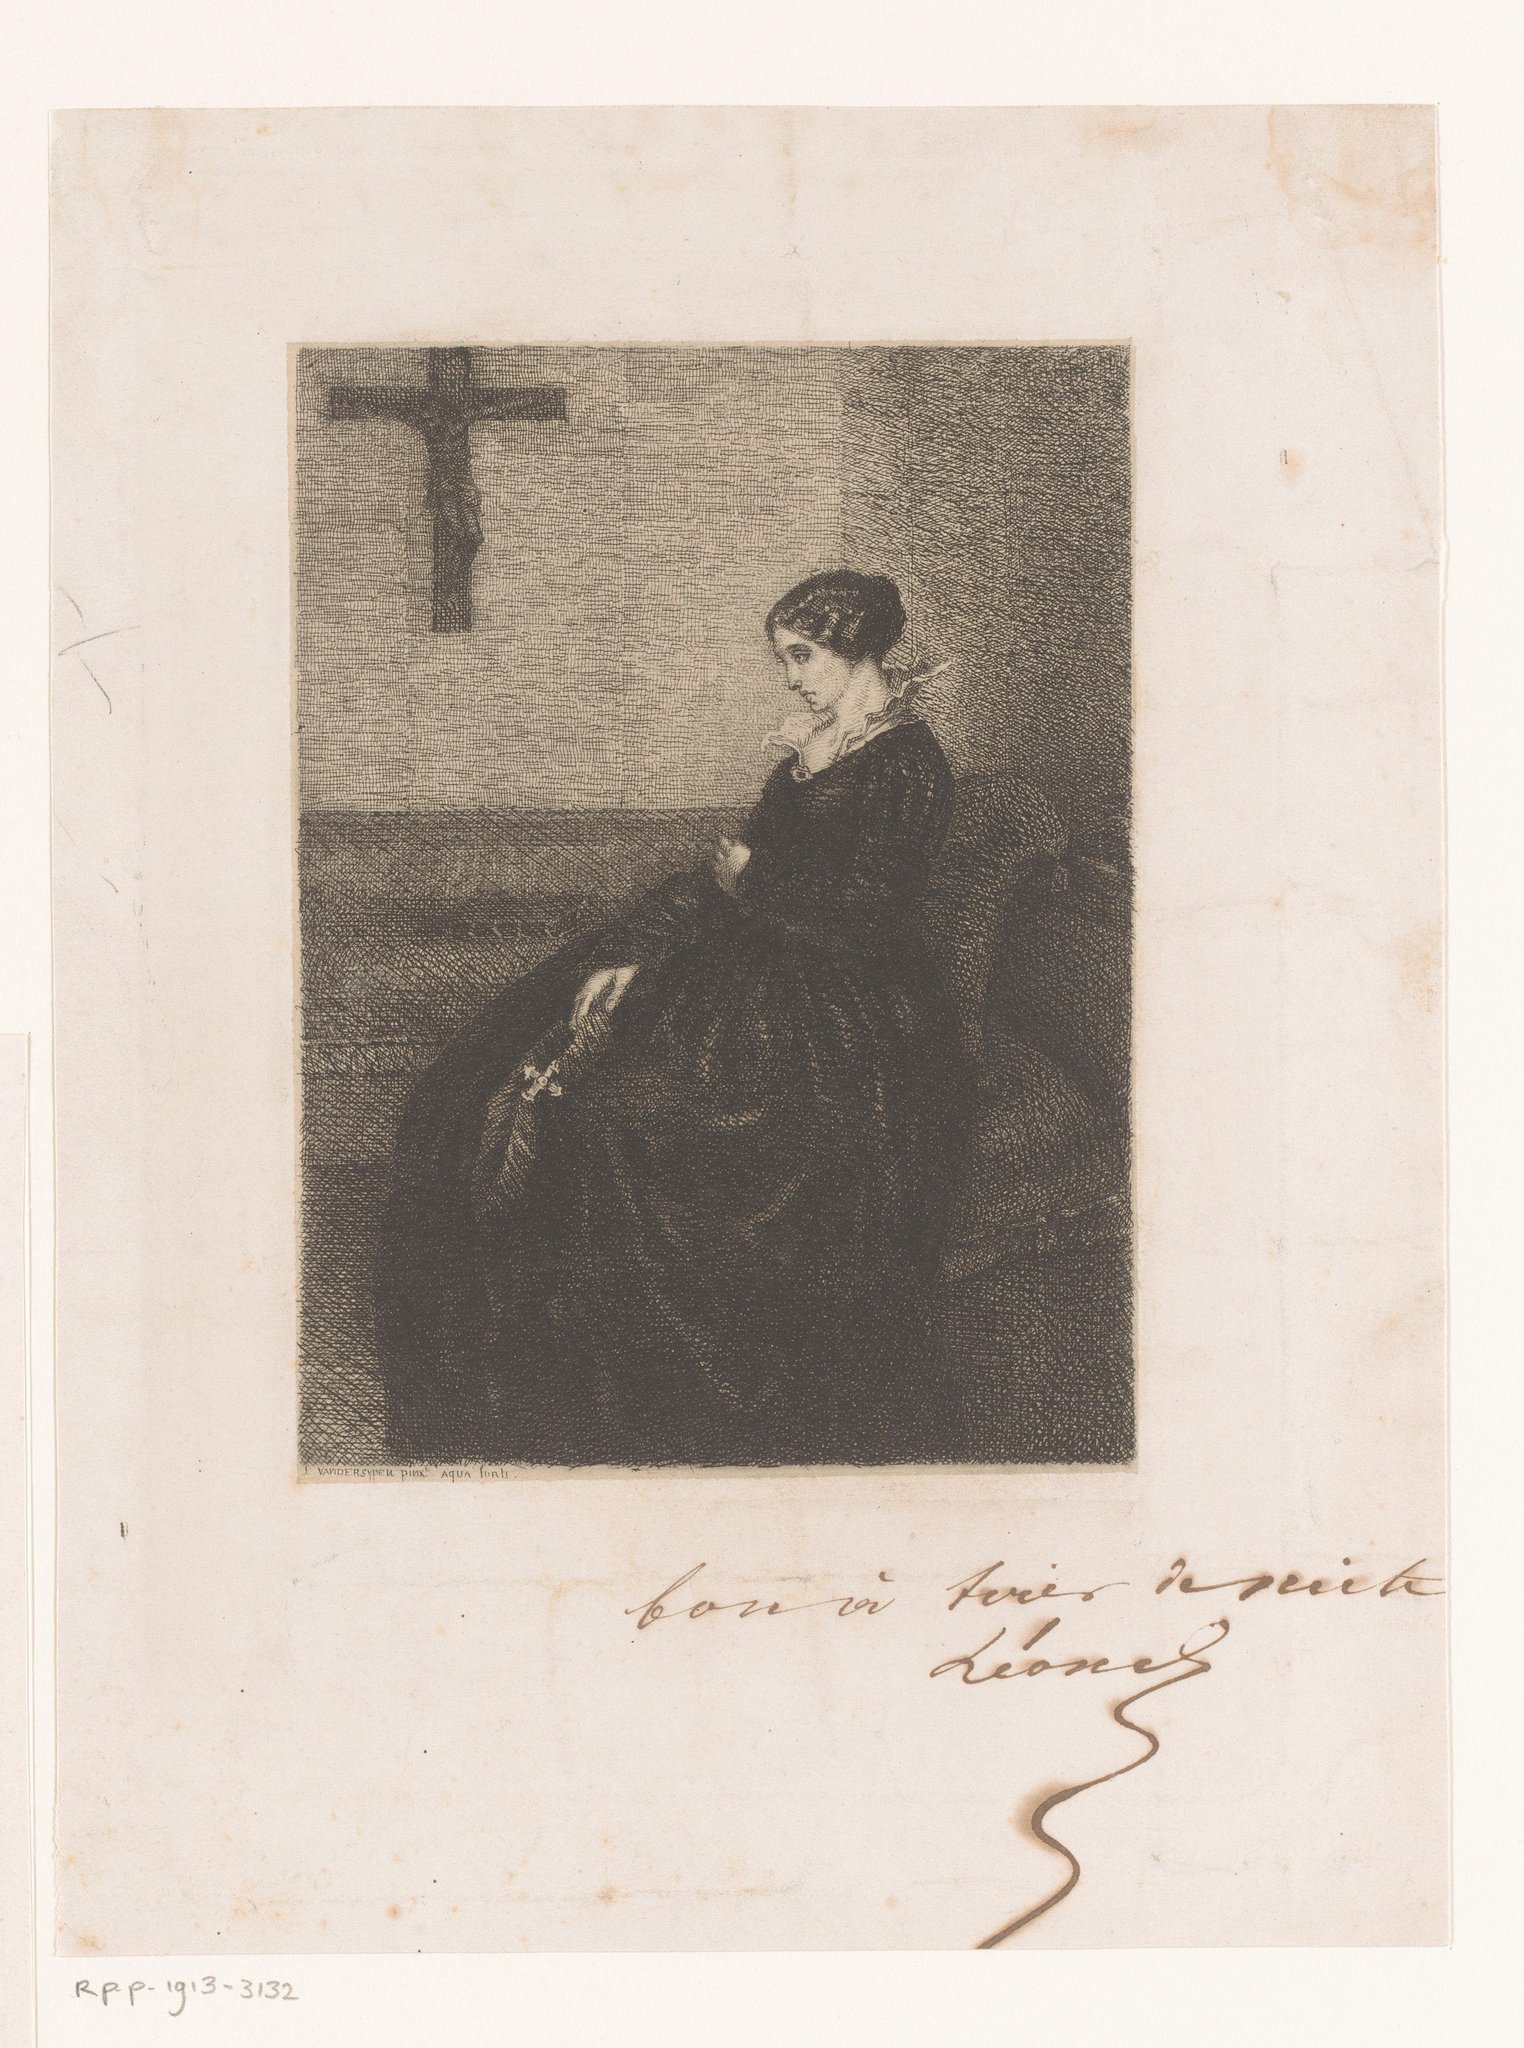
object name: print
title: Vrouw zittend op een bank met aan de muur een crucifix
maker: l. van der sypen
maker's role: print maker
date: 1850-1899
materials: paper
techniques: etching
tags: adult woman, crucifix ~ personal devotion, veil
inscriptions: collector's mark: Lugt 1485, inscription: ‘[...] de nuite. Leon’, collector's mark: Lugt 2228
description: Volgens Hippert&Linnig verschenen in: l'Album de la Fête artistique à Bruxelles, 1850, pl. 15.